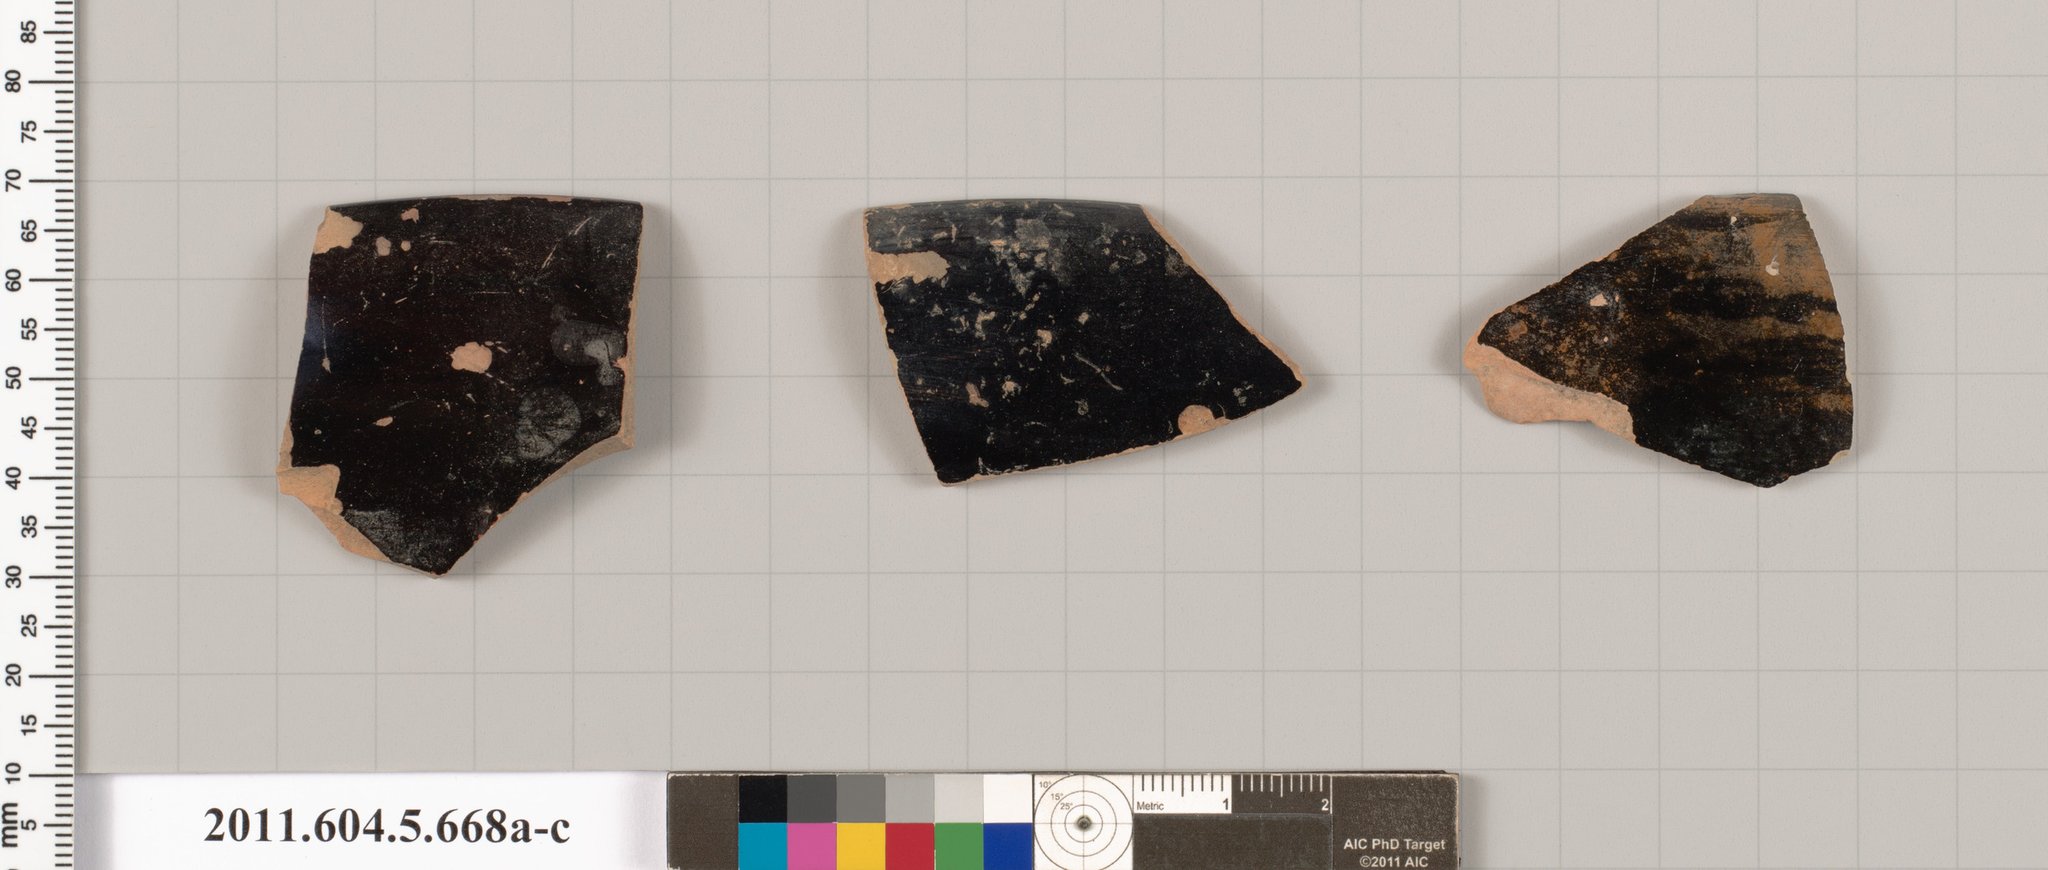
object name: kylix fragment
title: Terracotta rim fragments of kylikes (drinking cups)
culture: greek, attic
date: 600-401 BCE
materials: terracotta